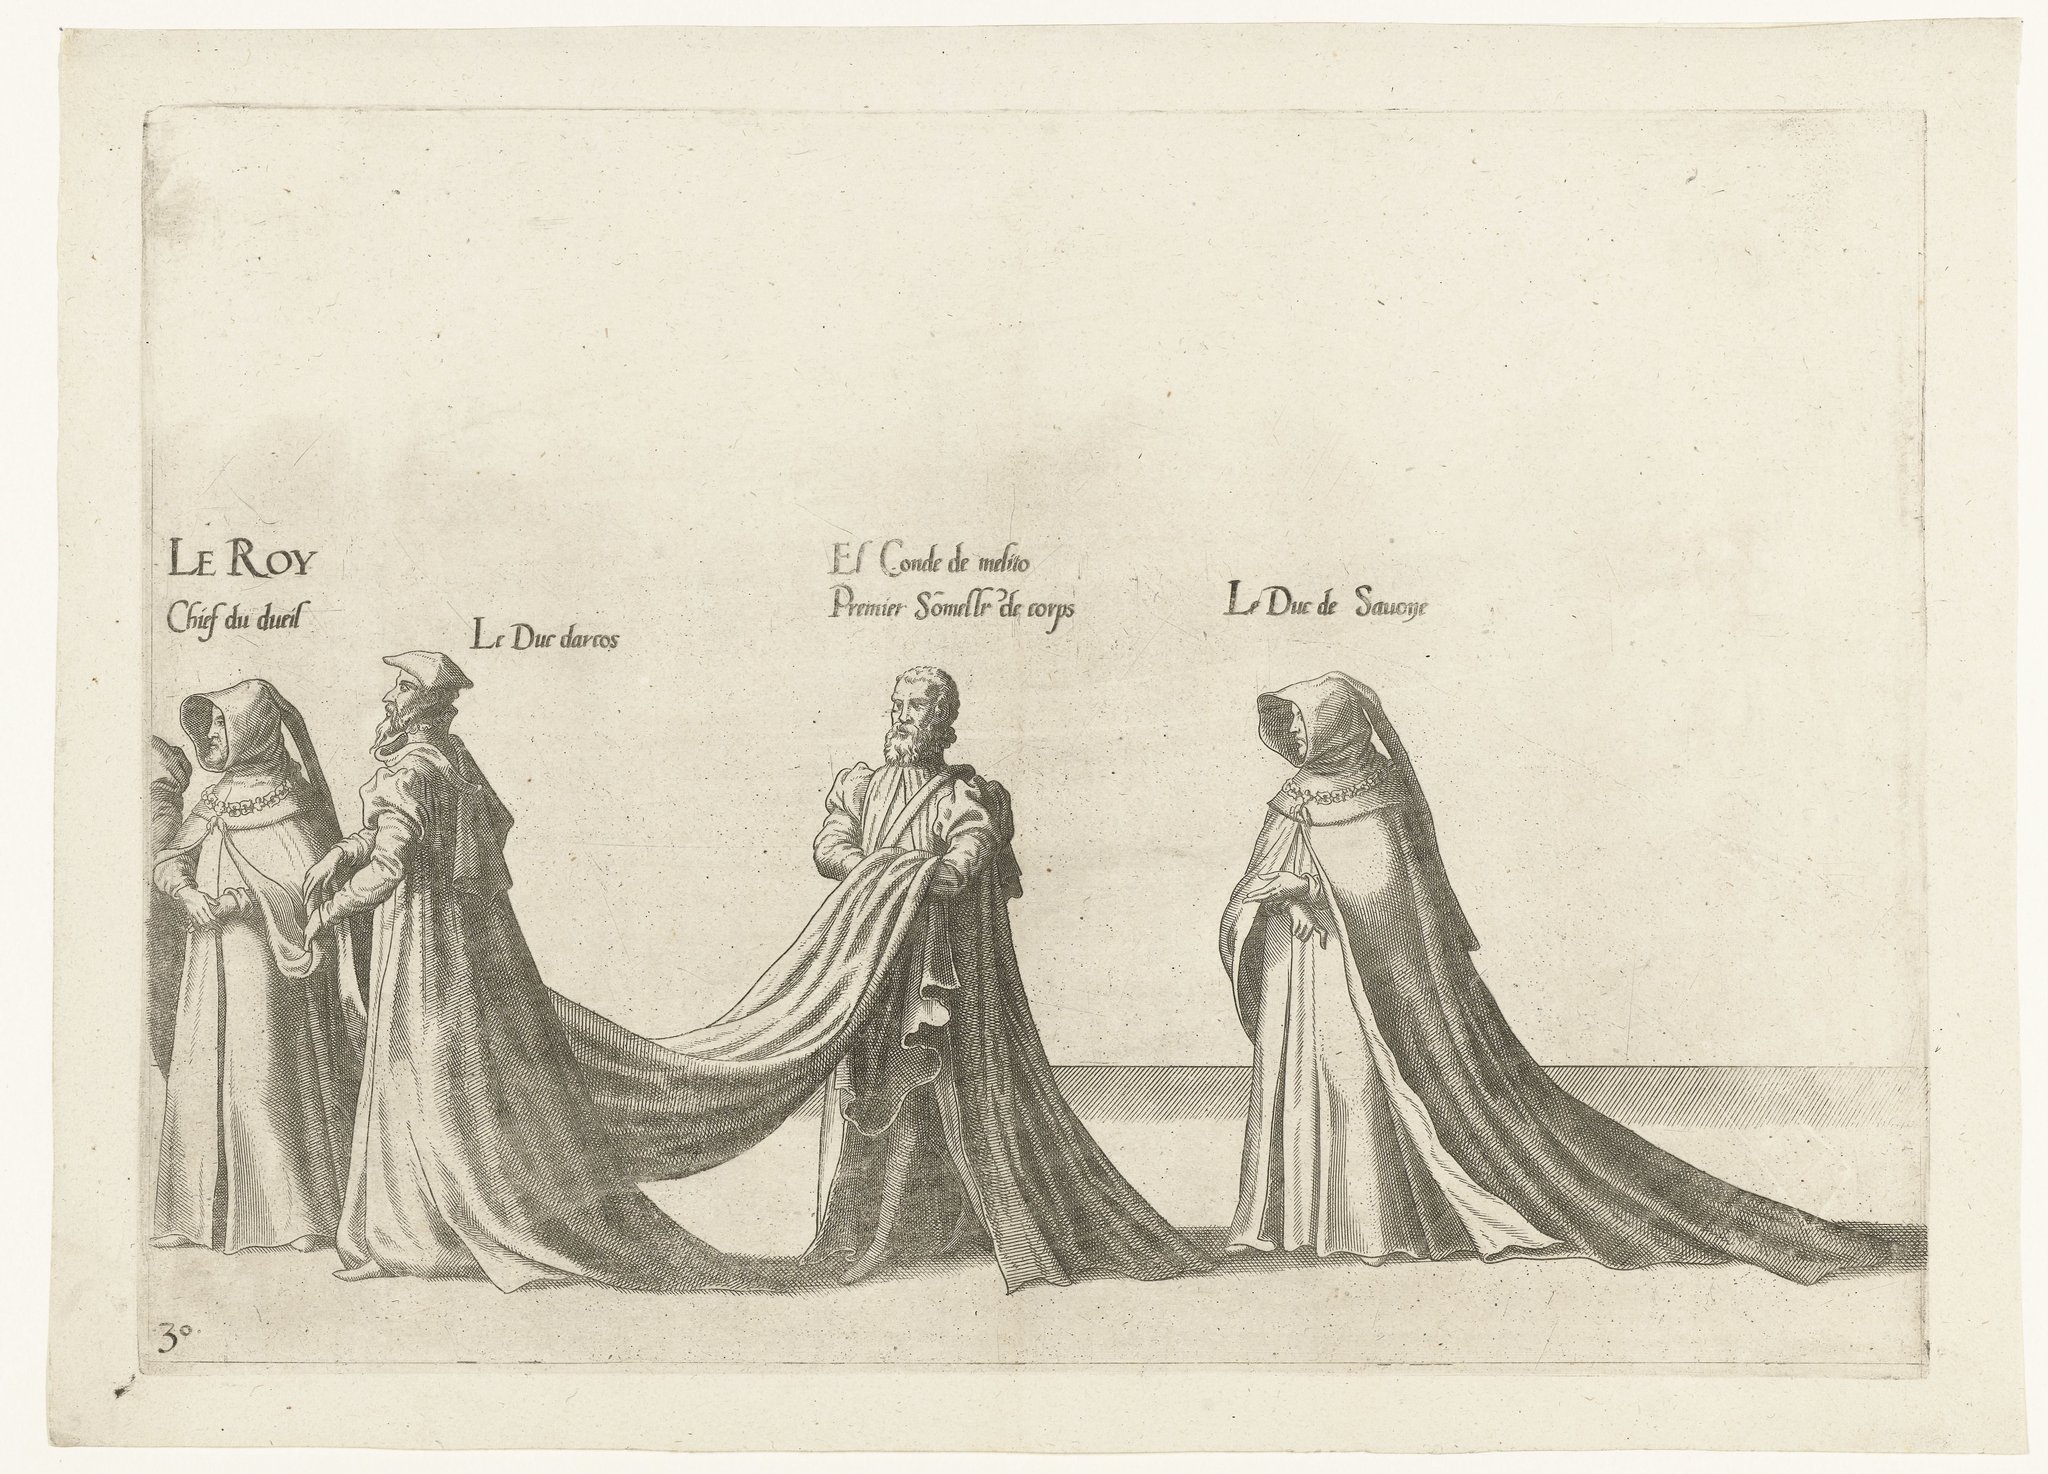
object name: print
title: Begrafenisoptocht van keizer Karel V, 1558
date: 1559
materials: paper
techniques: engraving, etching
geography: southern netherlands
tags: philip ii of spain, ghent, charles v (holy roman emperor and king of spain), cortege, funeral procession, brussels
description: Vier edelen die deelnemen aan de optocht, waaronder Filips II. Onderdeel van de prentreeks van de Begrafenisoptocht van keizer Karel V op 29 december 1558 te Brussel.